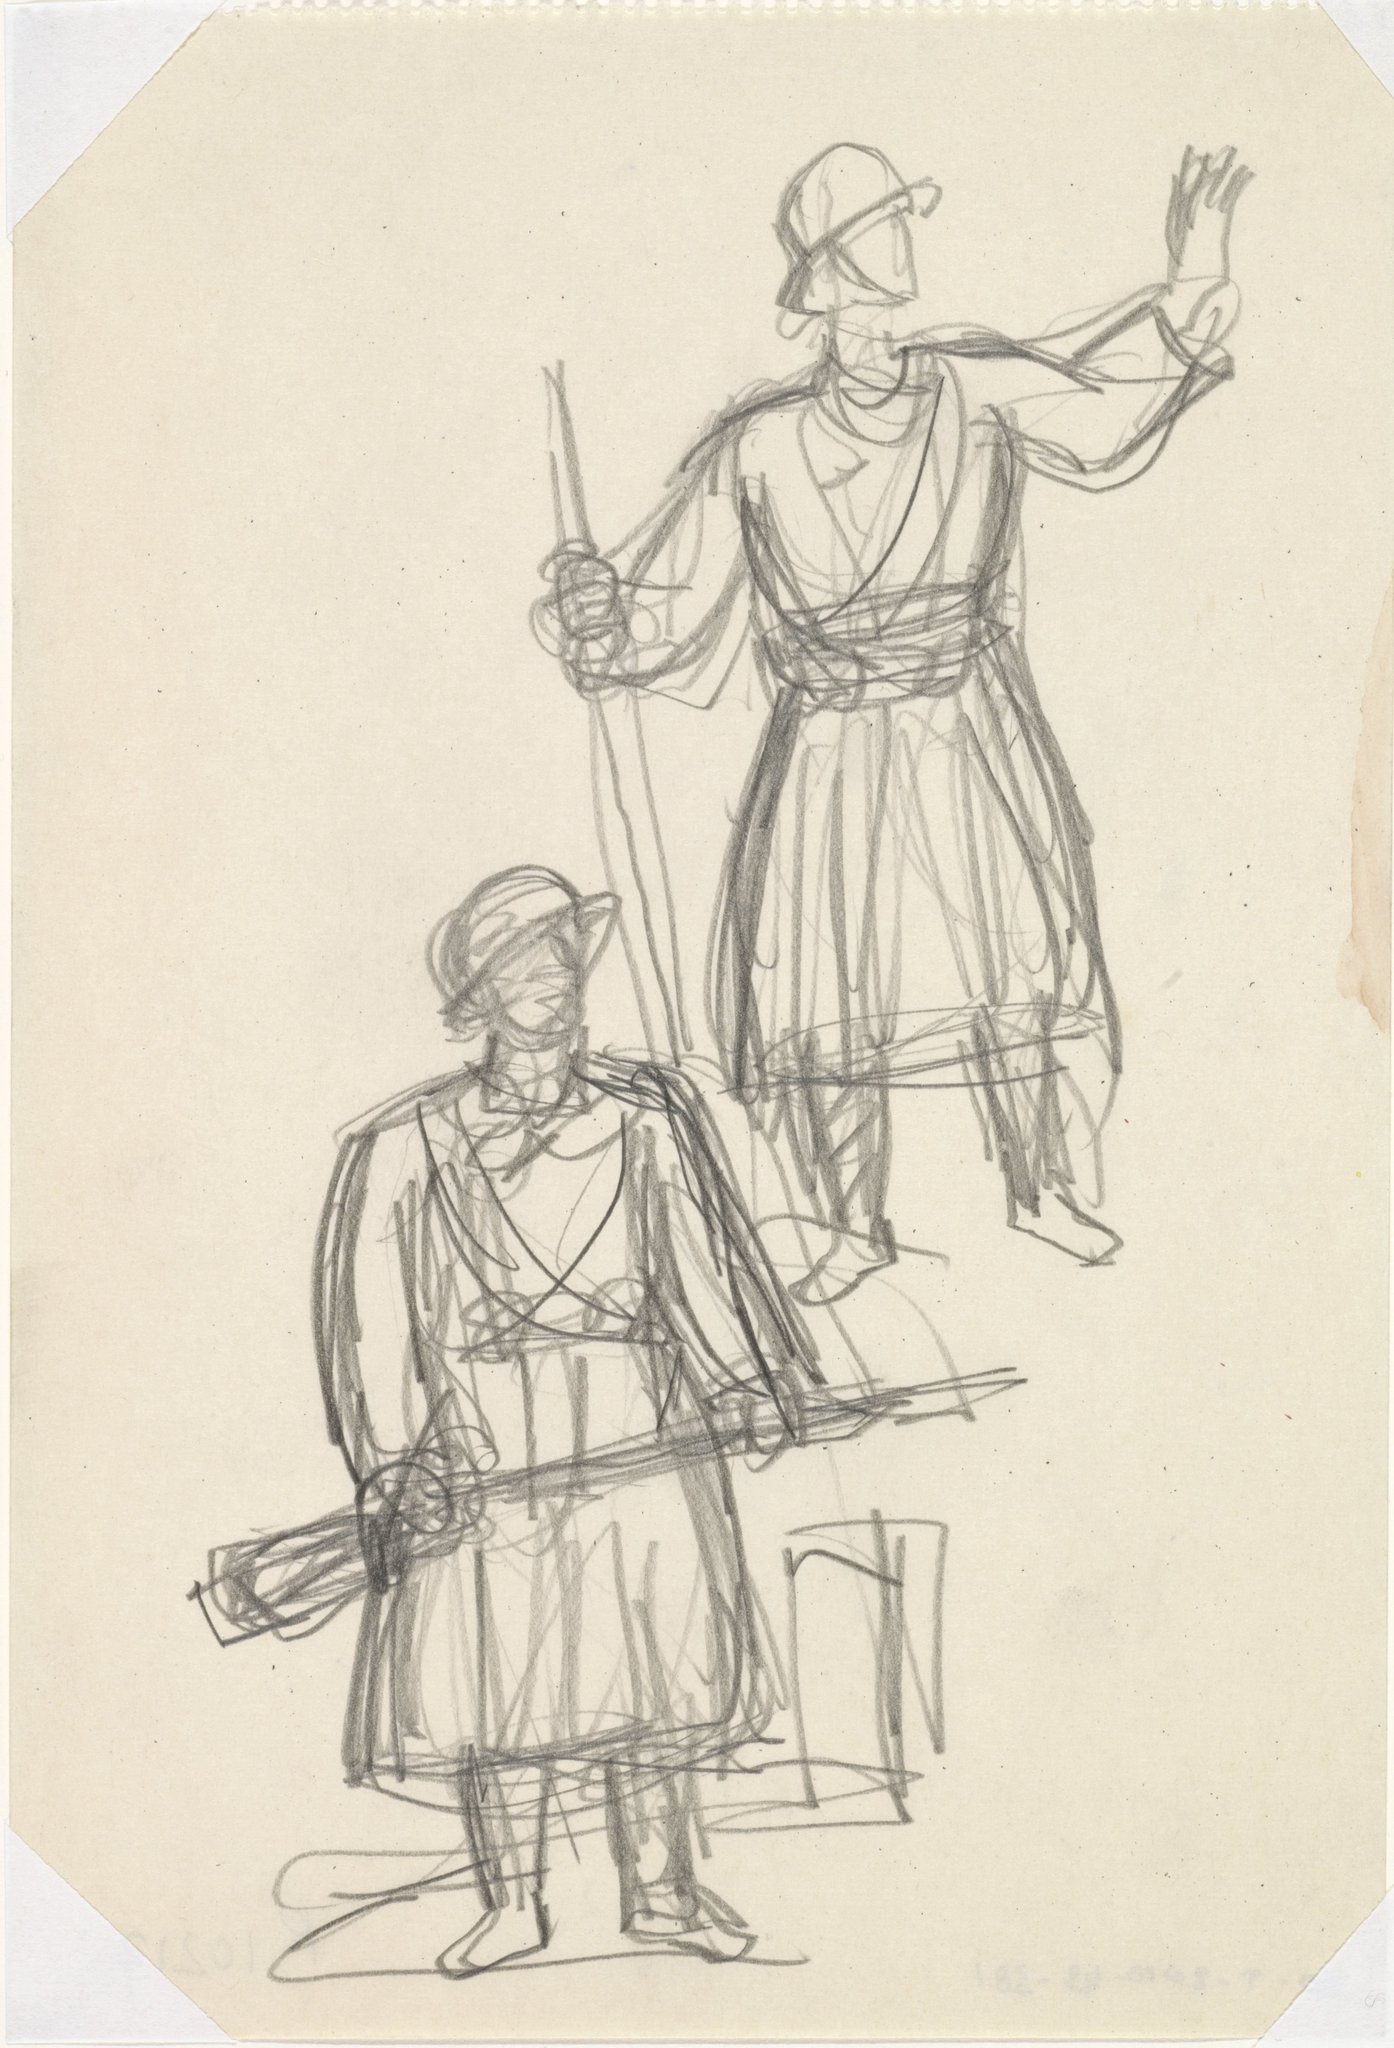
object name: drawing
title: Ontwerpschets affiche voor propaganda kunstbescherming in het leger, schets met twee soldaten.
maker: leo gestel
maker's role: draughtsman, print maker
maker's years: 1881-1941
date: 1939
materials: paper, pencil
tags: non-combatants ~ war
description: Blad met twee soldaten frontaal gezien, één die met linkerhand een stopteken maakt en een geweer in de rechterhand houdt, de ander houdt het geweer in beide handen voor zich.